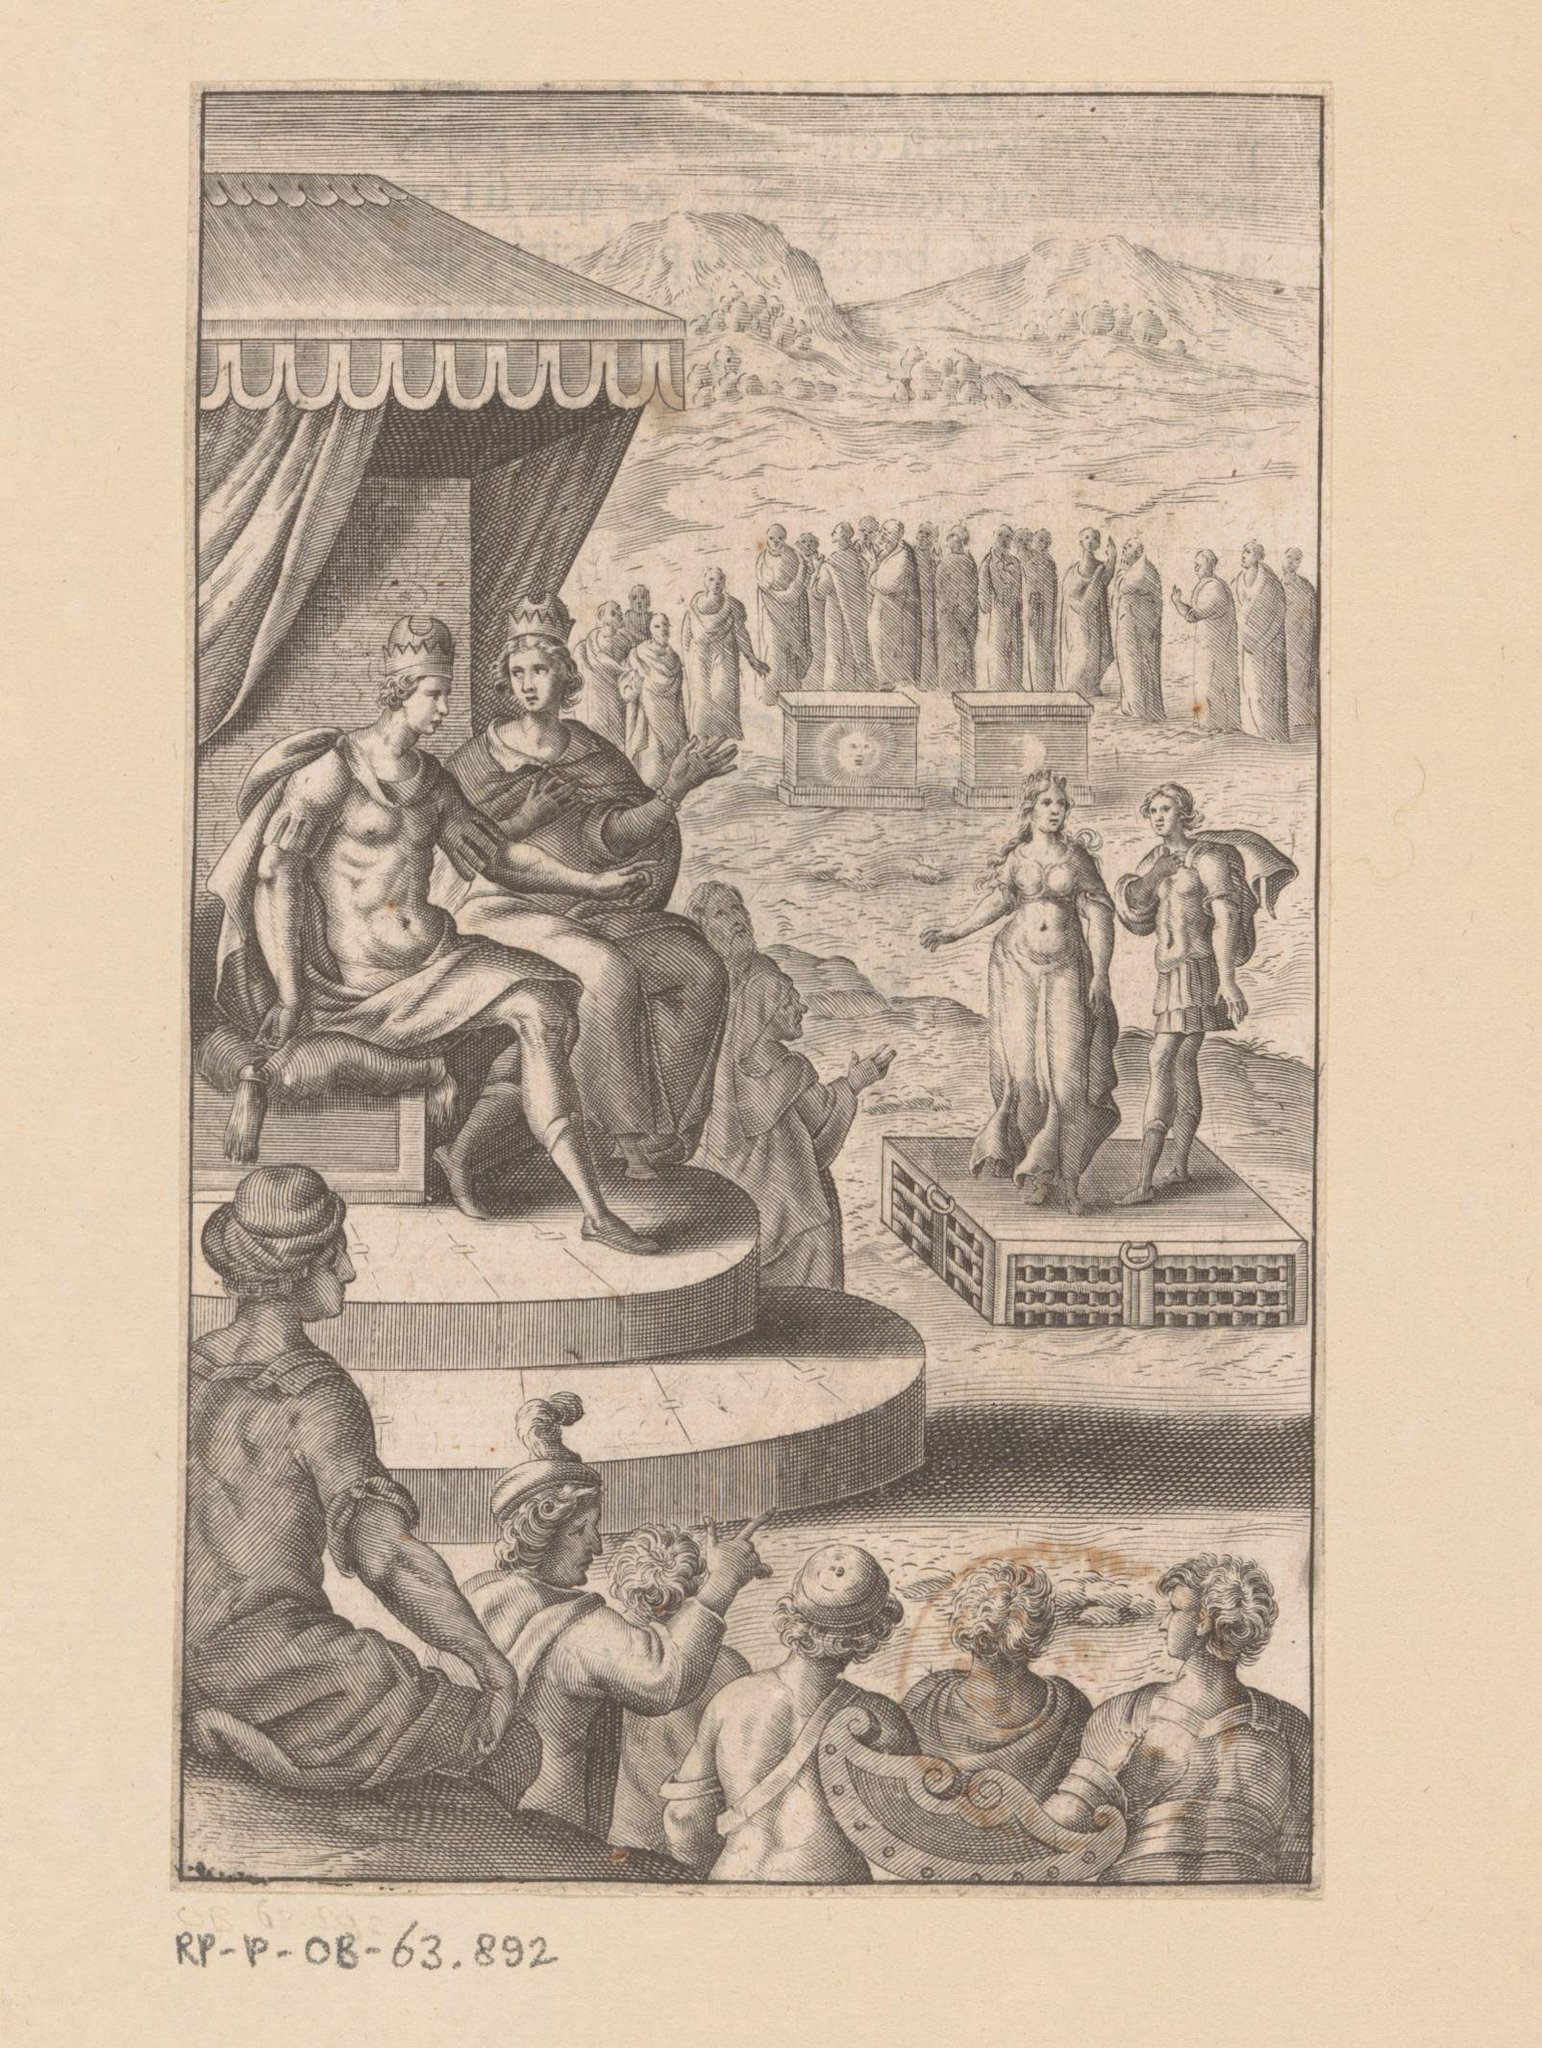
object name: print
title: Twee figuren voor een koning en koningin op een troon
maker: samuel thiboust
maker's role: printer, publisher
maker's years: -1635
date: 1623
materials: paper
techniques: engraving, letterpress printing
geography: paris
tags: throne, king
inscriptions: collector's mark: Lugt 240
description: Prent gebruikt voor: Emesenus, Heliodorus. Les amours de Théagène et Chariclée, / Histoire éthiopique de Heliodore. Parijs: Samuel Thiboust, 1623.